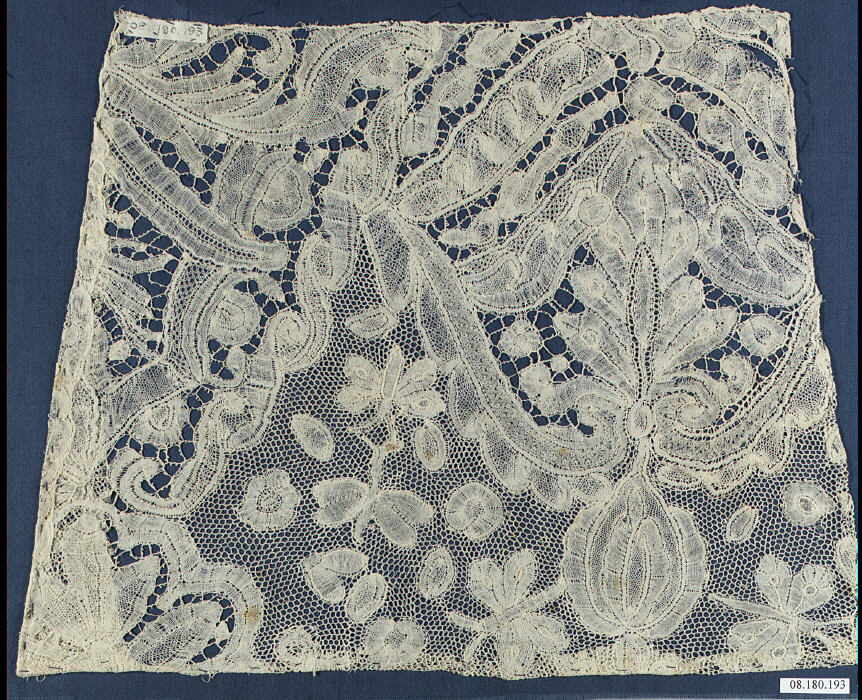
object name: piece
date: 1701-1800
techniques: lace